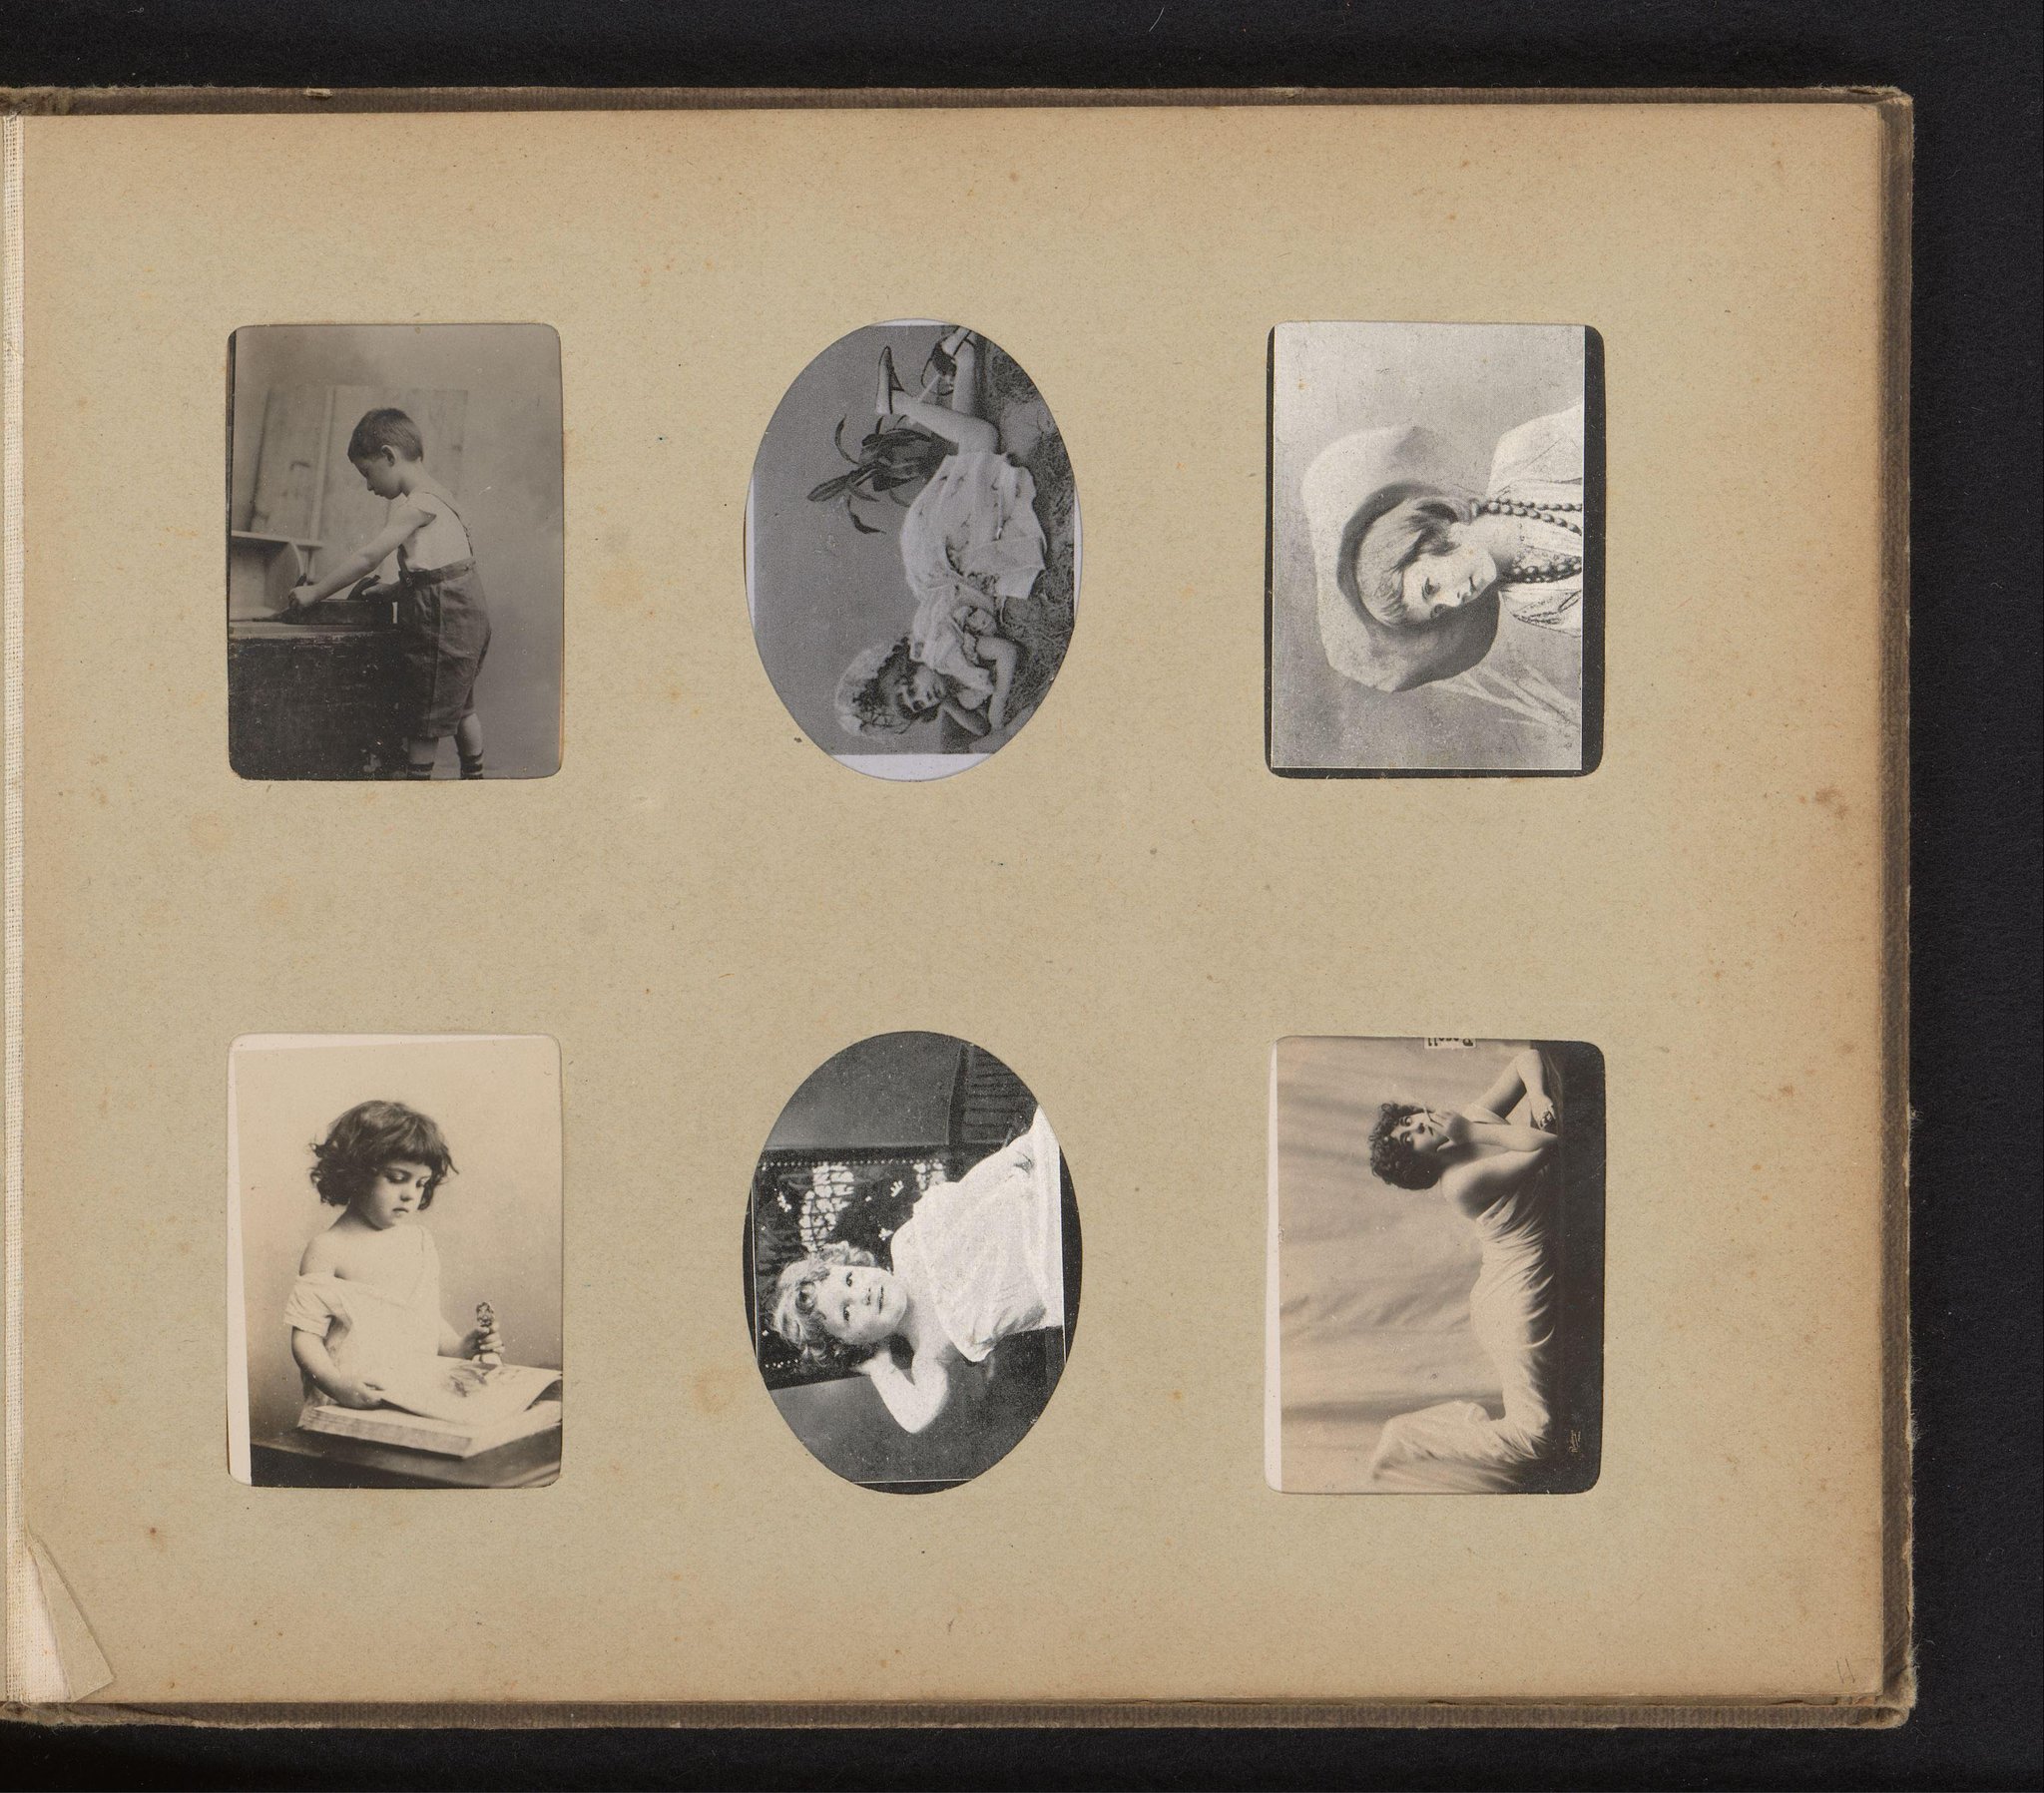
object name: album leaf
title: Portretten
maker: Anonymous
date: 1890-1900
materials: cardboard, paper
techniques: photograph, gelatin silver print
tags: adolescent, young woman, maiden, child (at home)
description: Zes portretten waarvan drie van kinderen en drie van jonge vrouwen. Deze pagina is deel van een album.